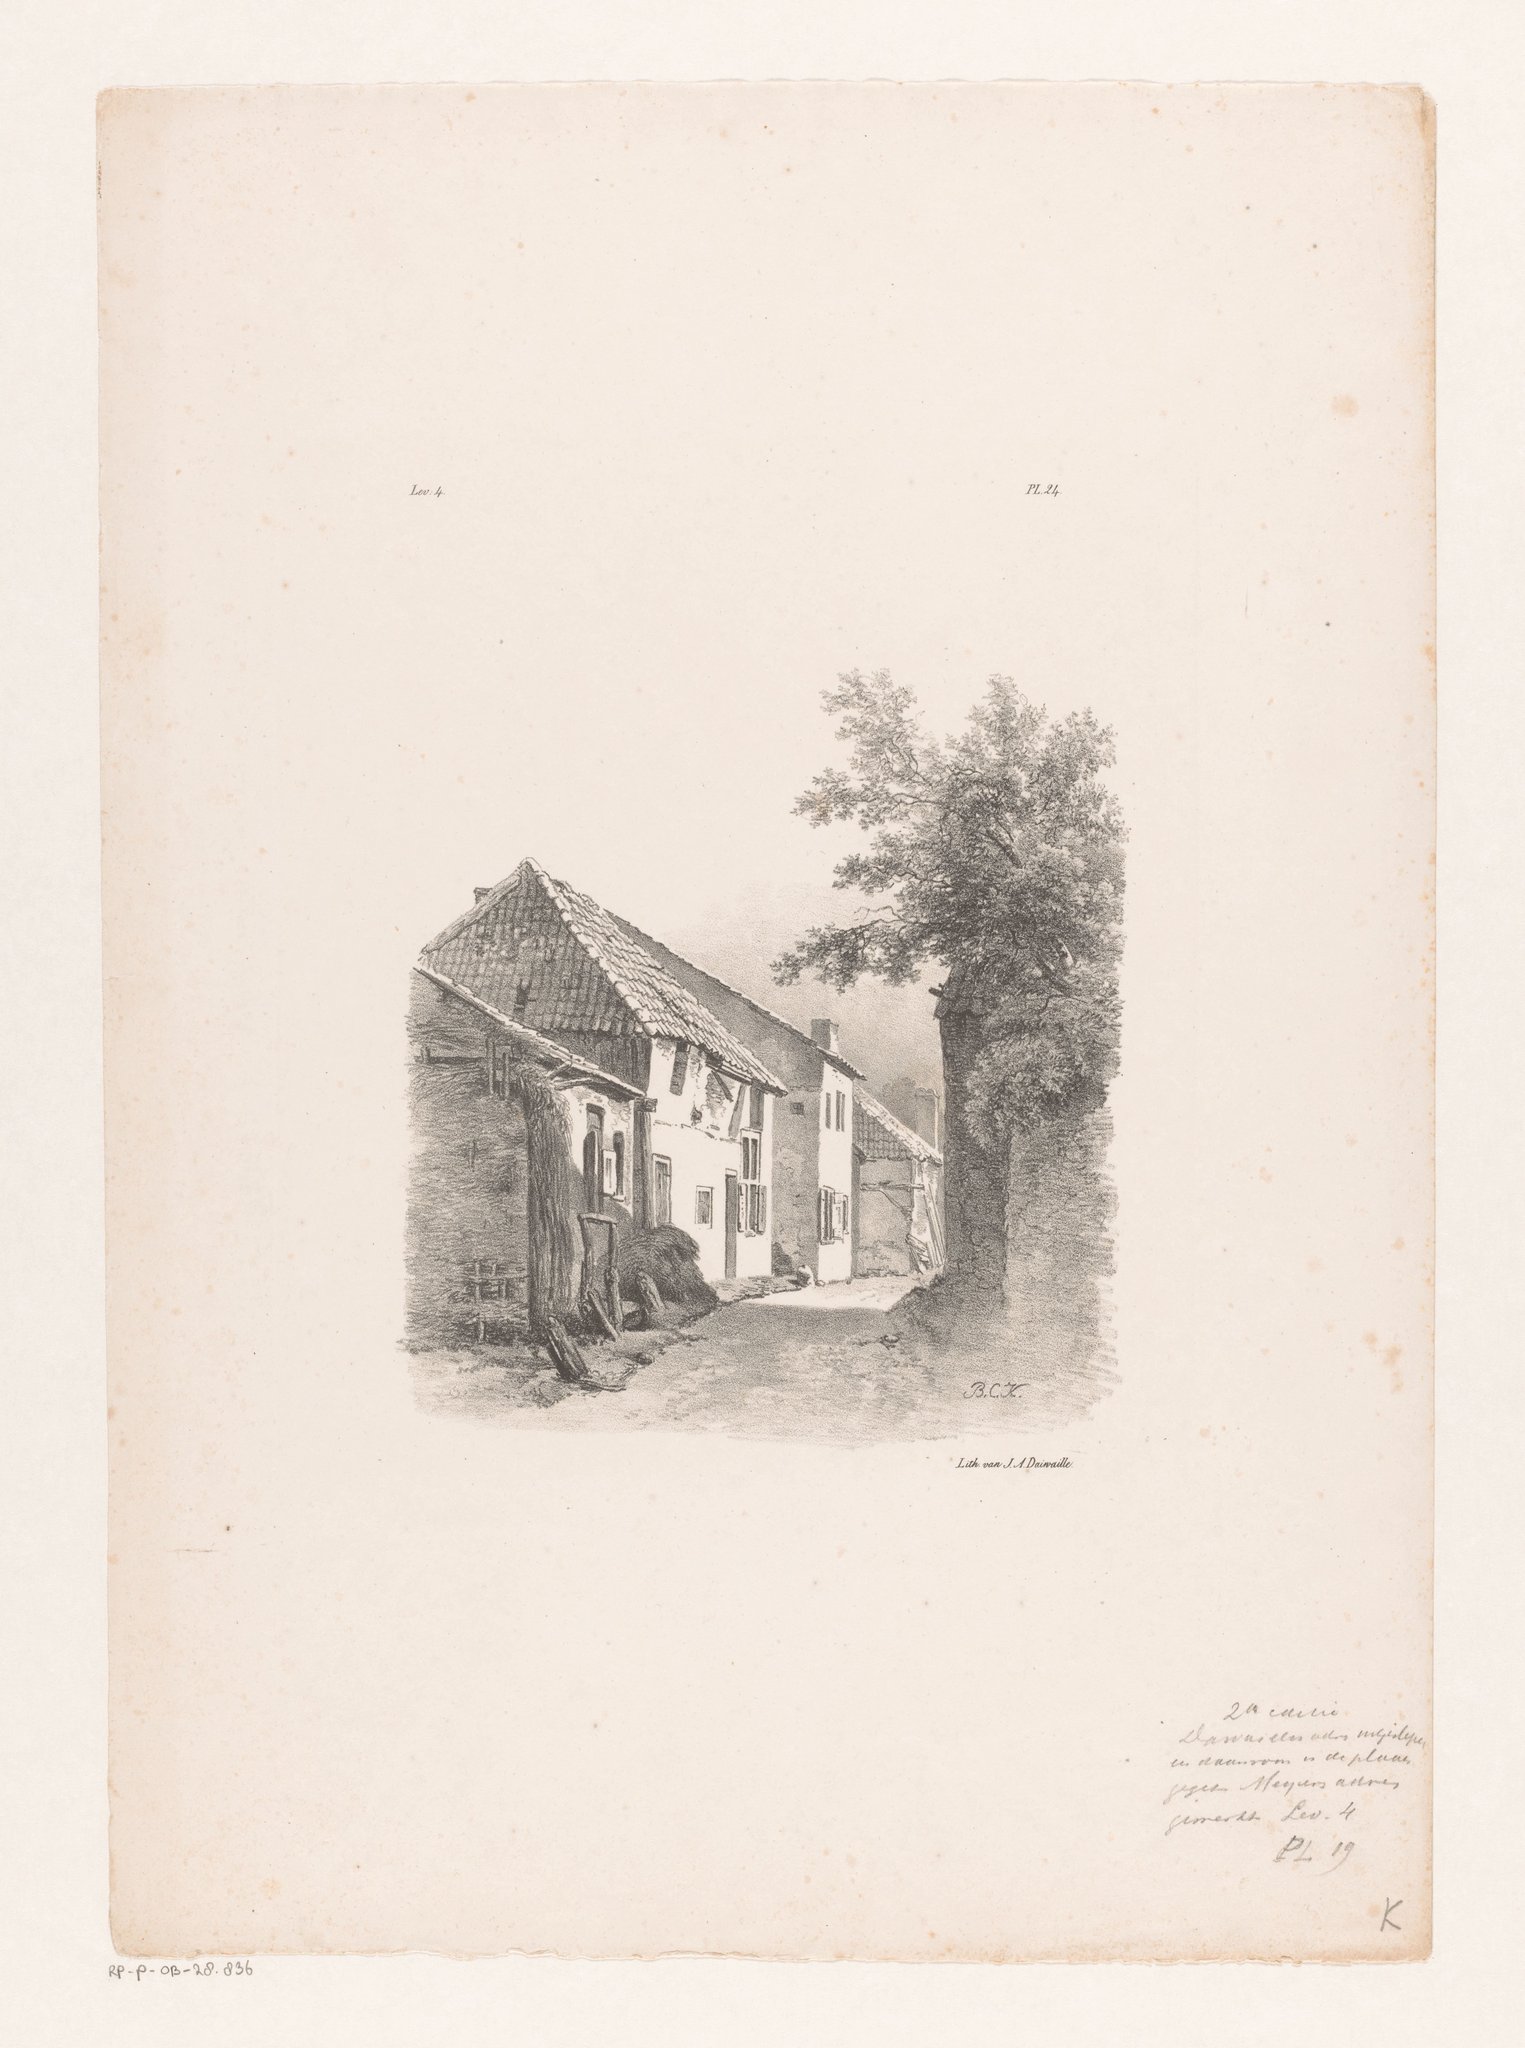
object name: print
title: Boerderij aan een weg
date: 1829-1830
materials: paper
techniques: lithograph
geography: amsterdam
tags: public road, farm (building)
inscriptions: inscription: ‘2de editie / Daiwaille adres ingeslepen / en daarvoor in de plaats / gegeven Meyers adres / gemerkt Lev 4 / PL 19 / K’, collector's mark: Lugt 2228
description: In 1829 en 1830 gaf Koekkoek, samen met Daiwaille, zes cahiers uit met ieder zes prenten getiteld Landschapstudiën. Deze werden gebruikt in het tekenonderwijs. Vijftien jaar later werd deze reeks, in een andere samenstelling nogmaals uitgegeven door Meyer en Comp in Amsterdam. Zie: De Bruyn Kops, 1963.